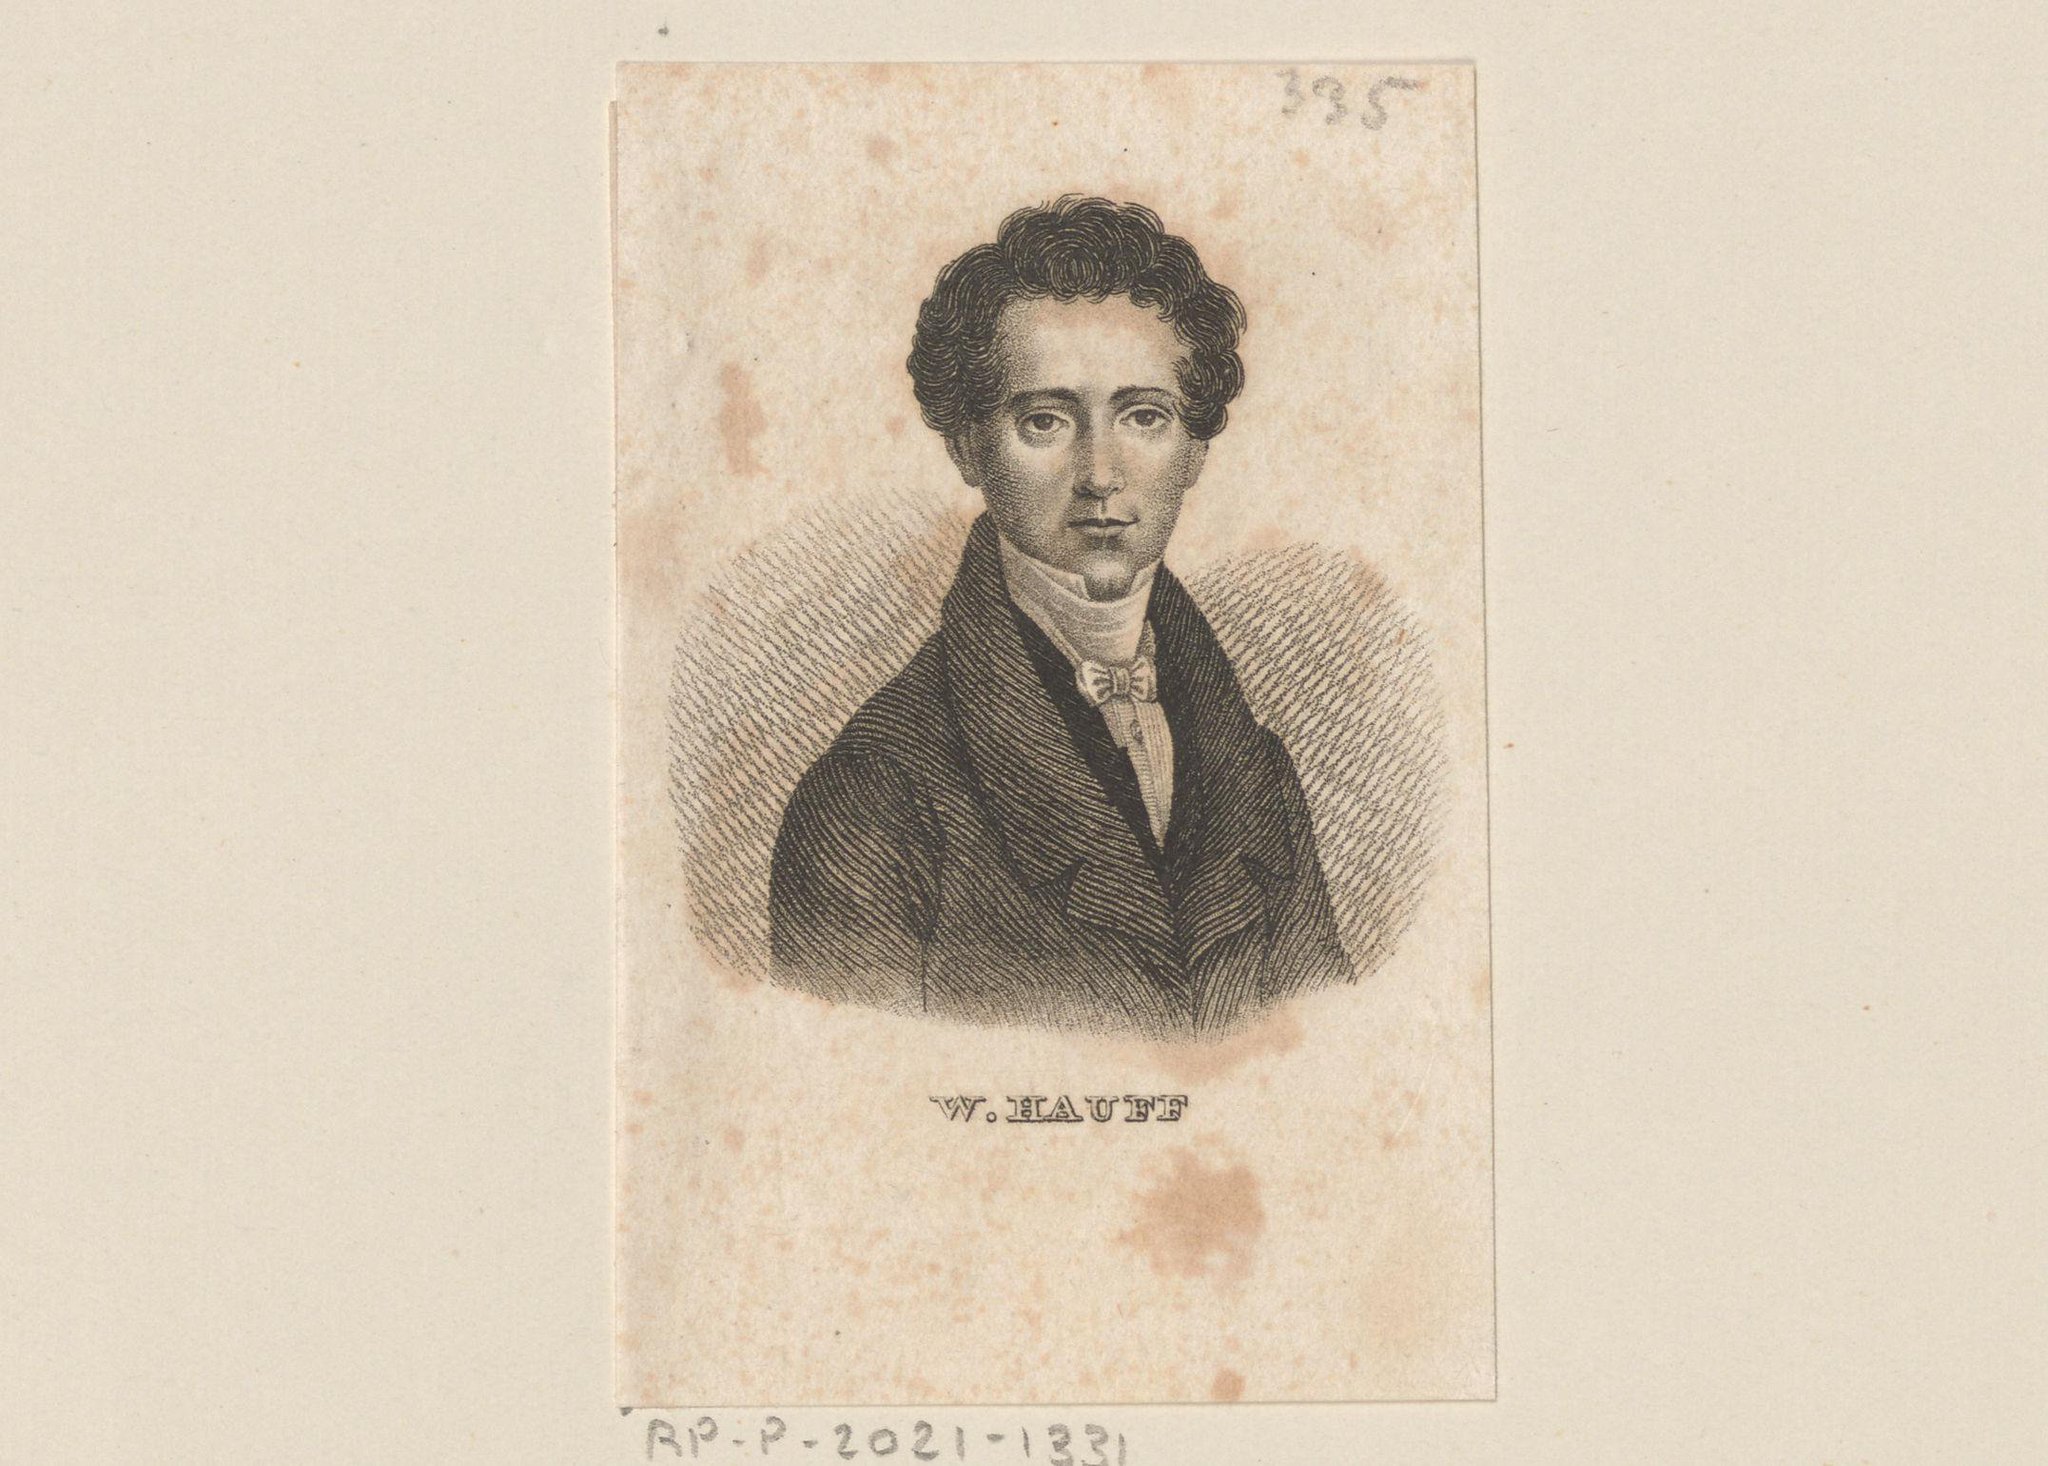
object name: print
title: Portret van Wilhelm Hauff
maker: Anonymous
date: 1825-1874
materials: paper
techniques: etching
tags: wilhelm hauff, historical persons, portrait of a writer